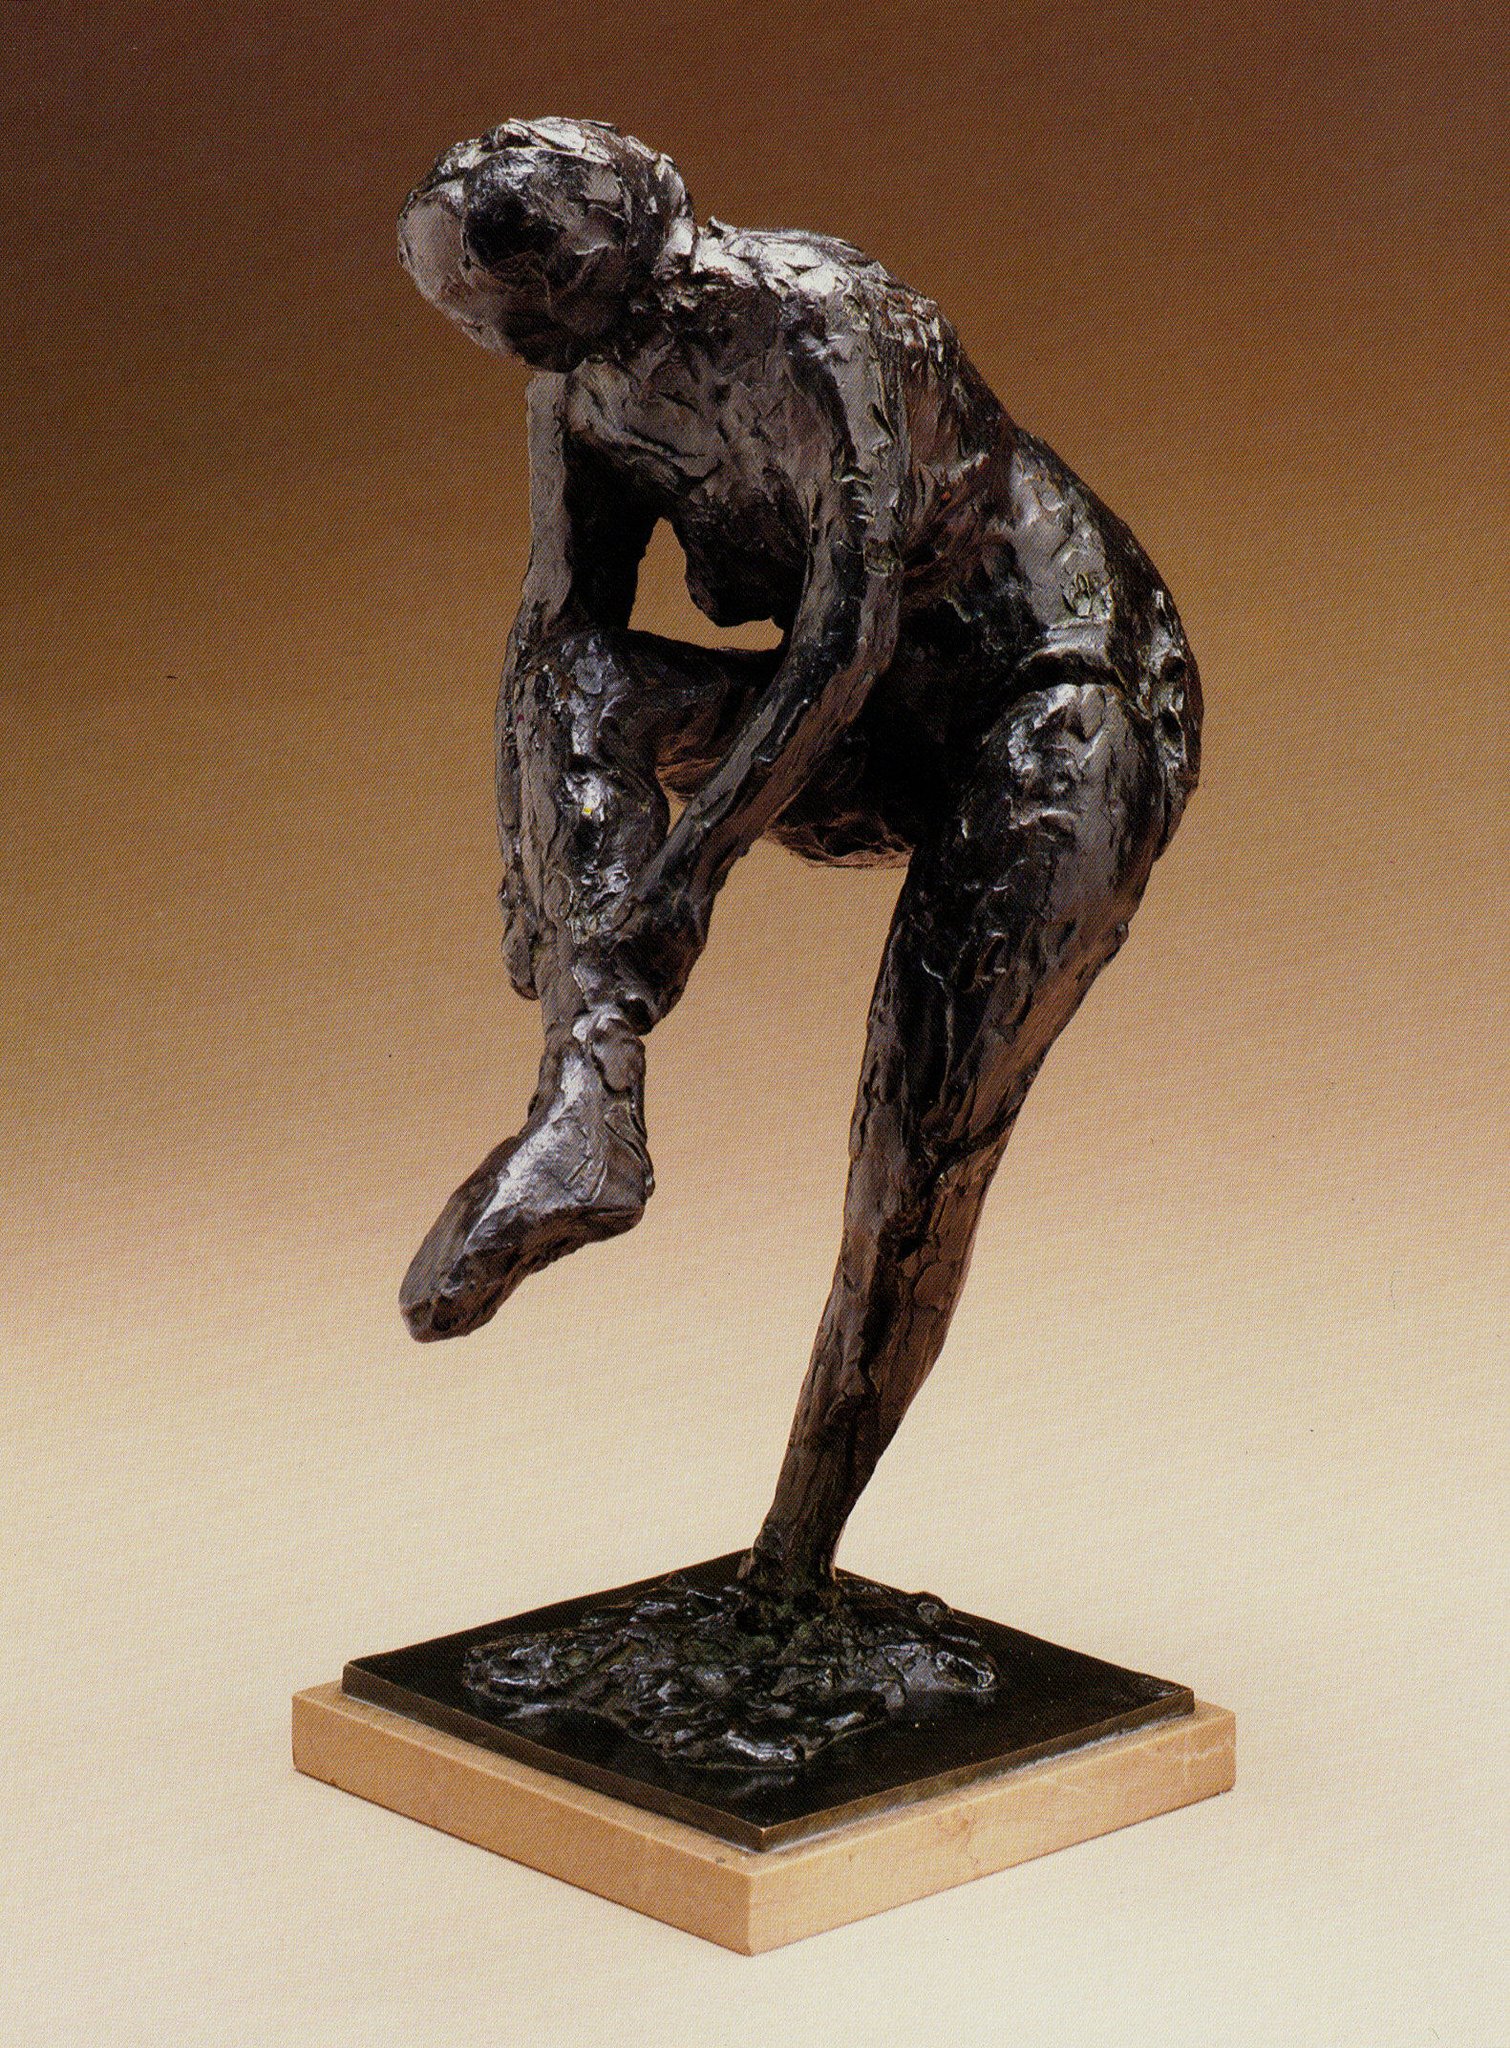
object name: sculpture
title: Woman Putting on a Stocking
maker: edgar degas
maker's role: artist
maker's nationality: french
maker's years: 1834-1917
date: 1895-1910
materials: bronze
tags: women